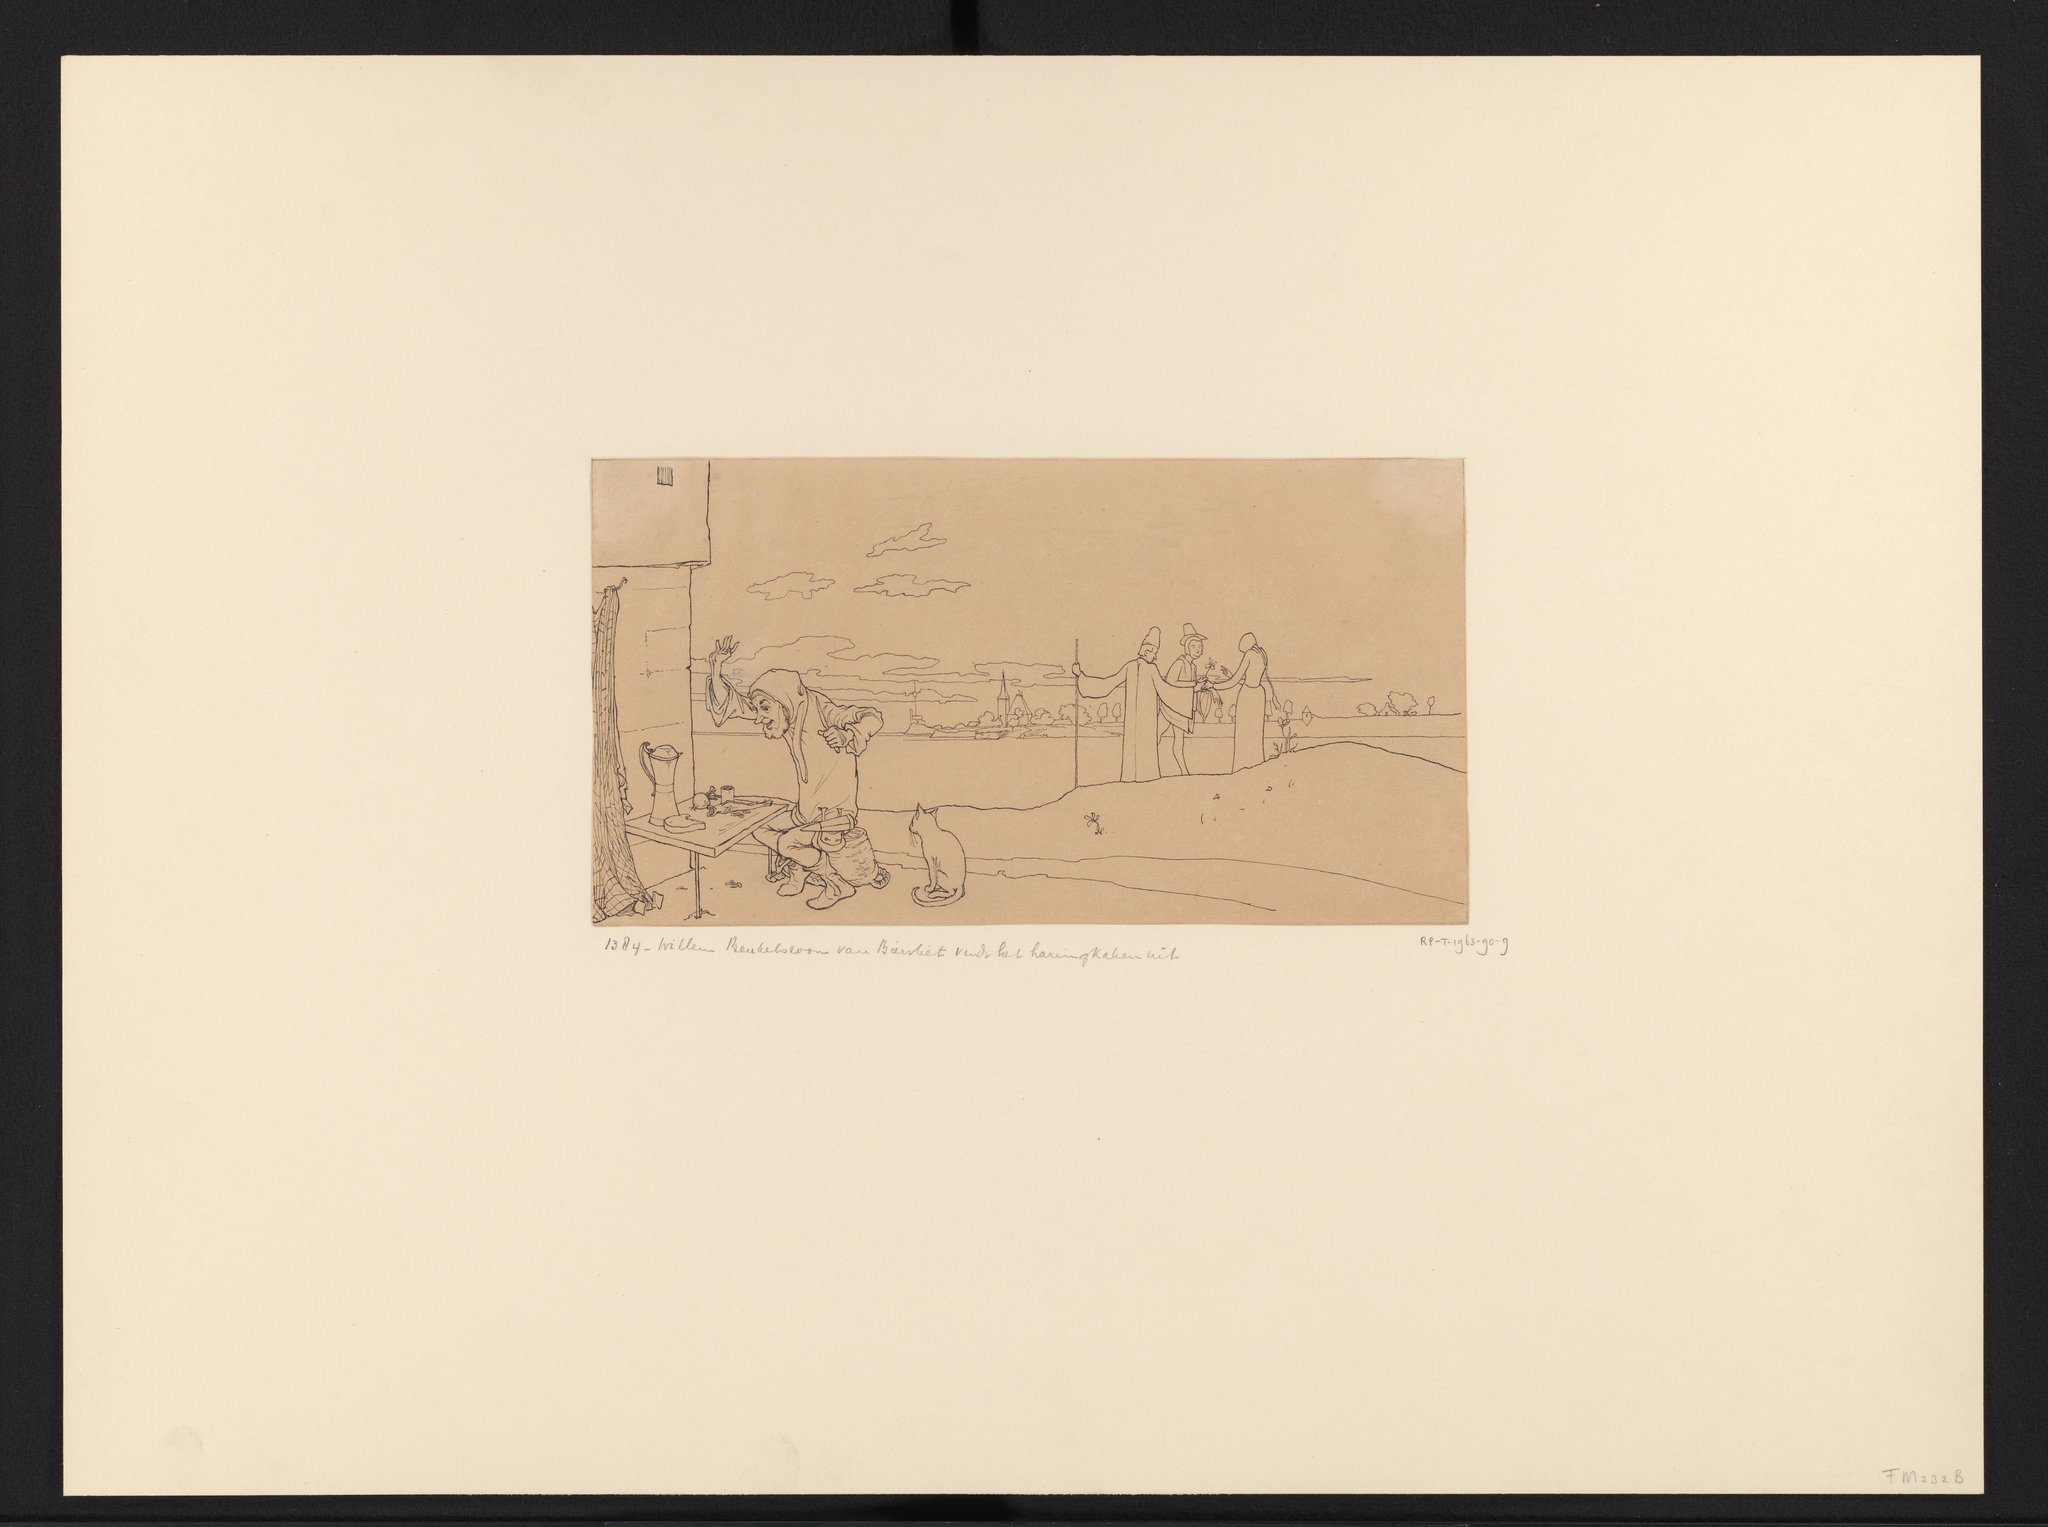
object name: drawing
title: 1384 / Willem Beukelszoon van Biervliet vindt het haringkaken uit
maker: johan huizinga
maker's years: 1872-1945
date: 1893-1895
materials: ink, paper, pencil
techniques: pen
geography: netherlands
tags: herring fishery, burgundian netherlands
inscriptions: collector's mark: Lugt 2228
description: Willem Beukelszoon van Biervliet vindt het haringkaken uit, 1384. Onderdeel van de map met 18 tekeningen gereproduceerd in Johan Huizinga's 'Keur van gedenkwaardige tafereelen uit de vaderlandsche historiën' uit 1950.